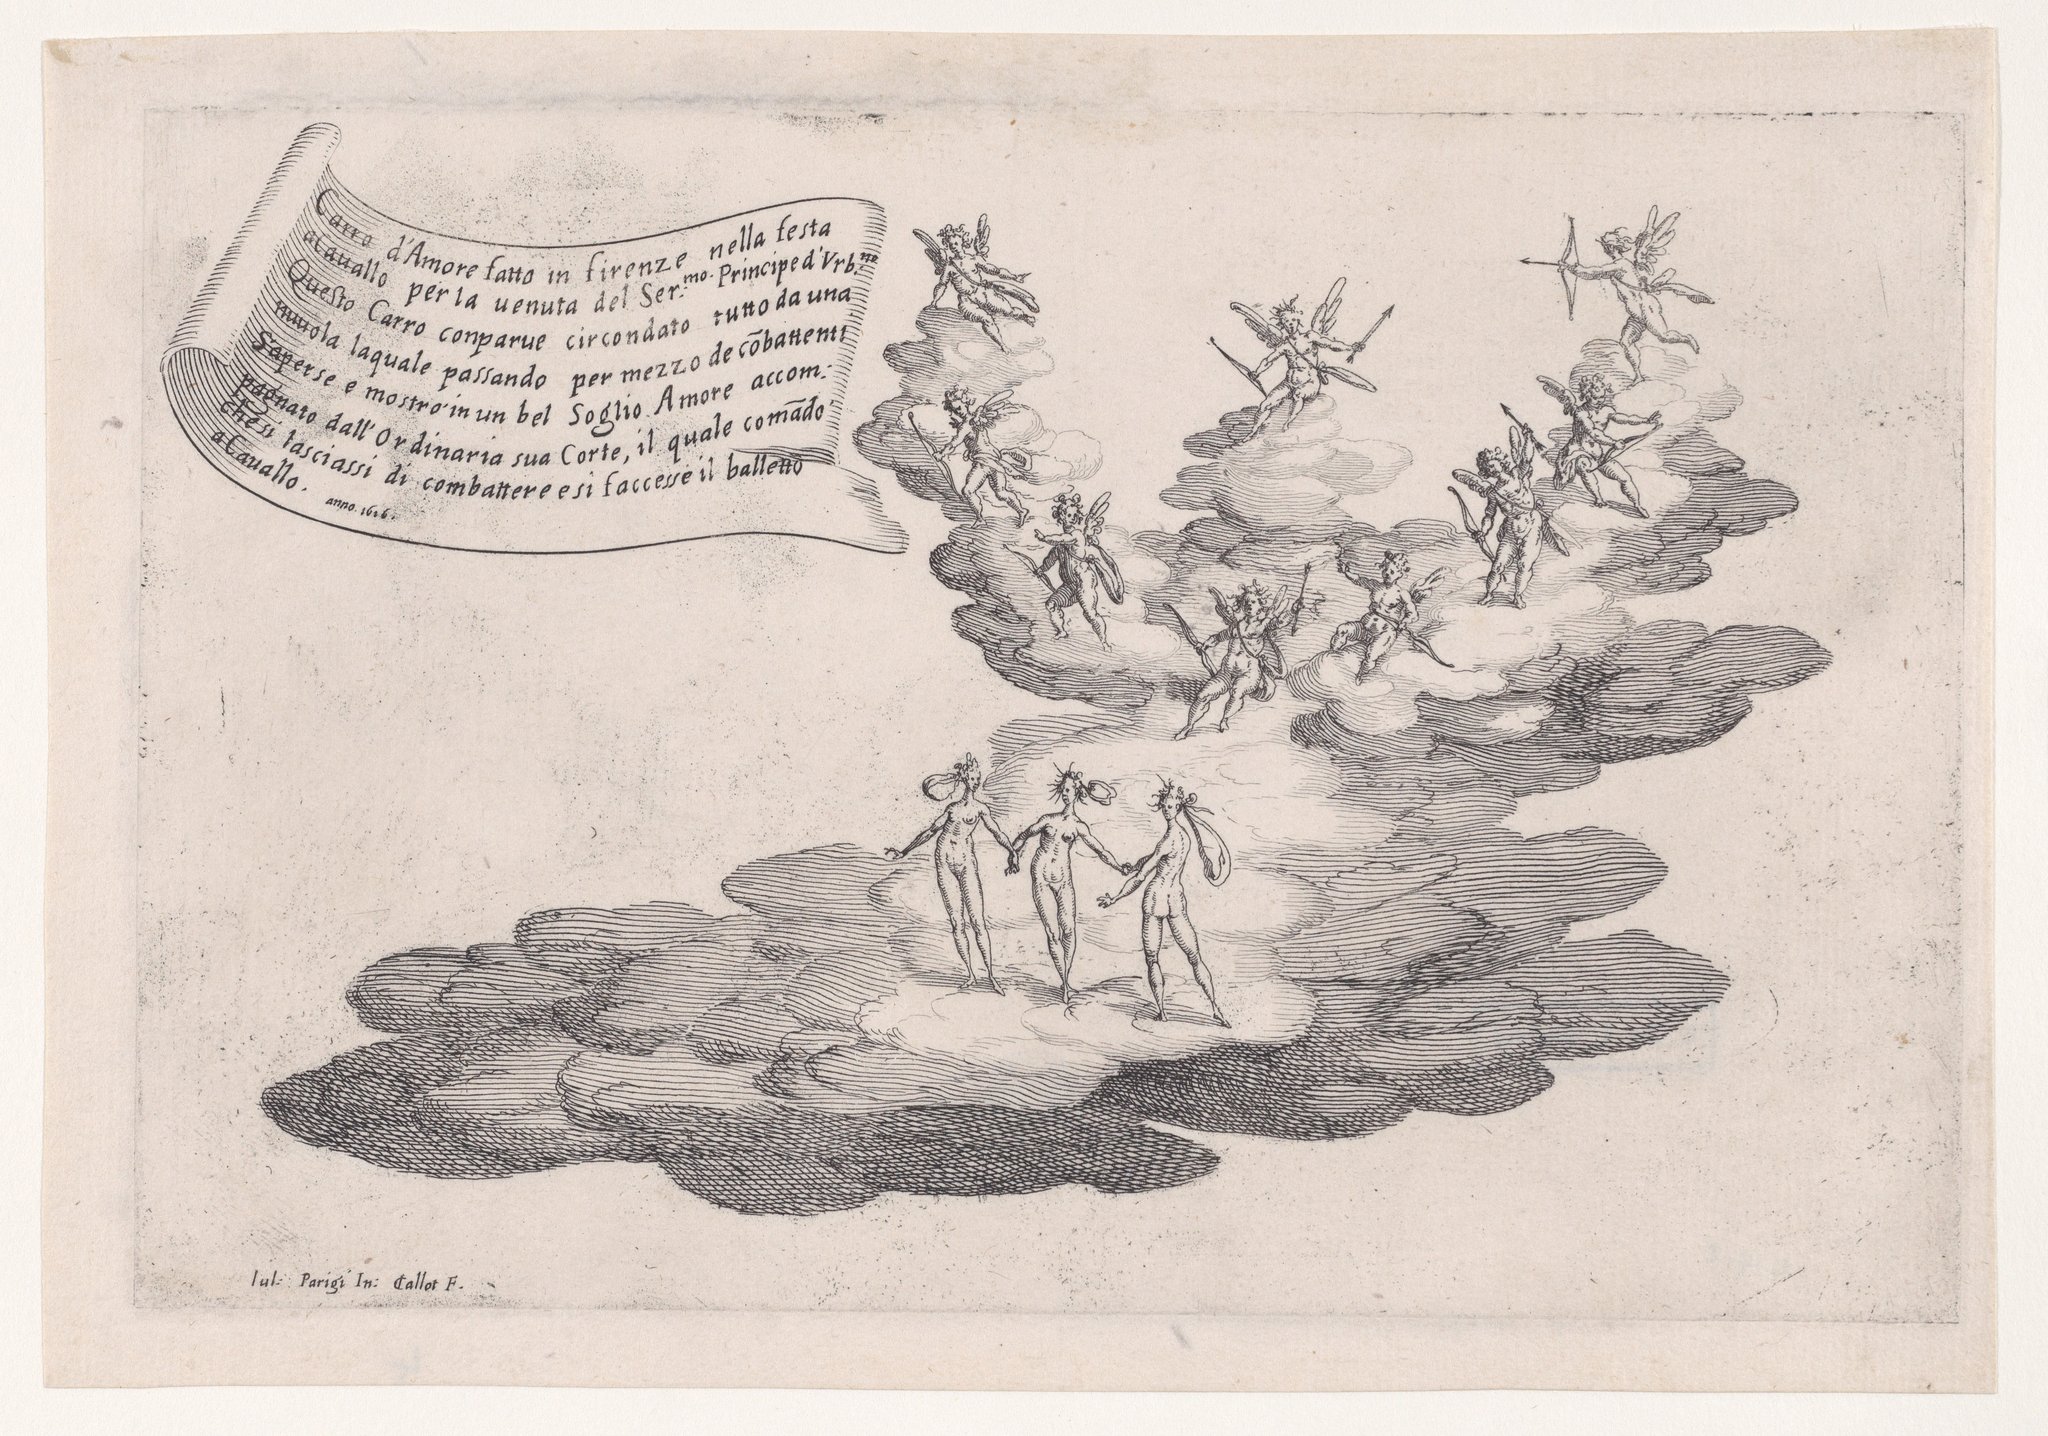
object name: print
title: Le Char de L'Amour, from "Guerre de Beauté" (Guerra di Bellezza) (War of Beauty)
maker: jacques callot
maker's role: artist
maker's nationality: french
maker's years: 1592-1635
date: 1616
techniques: etching